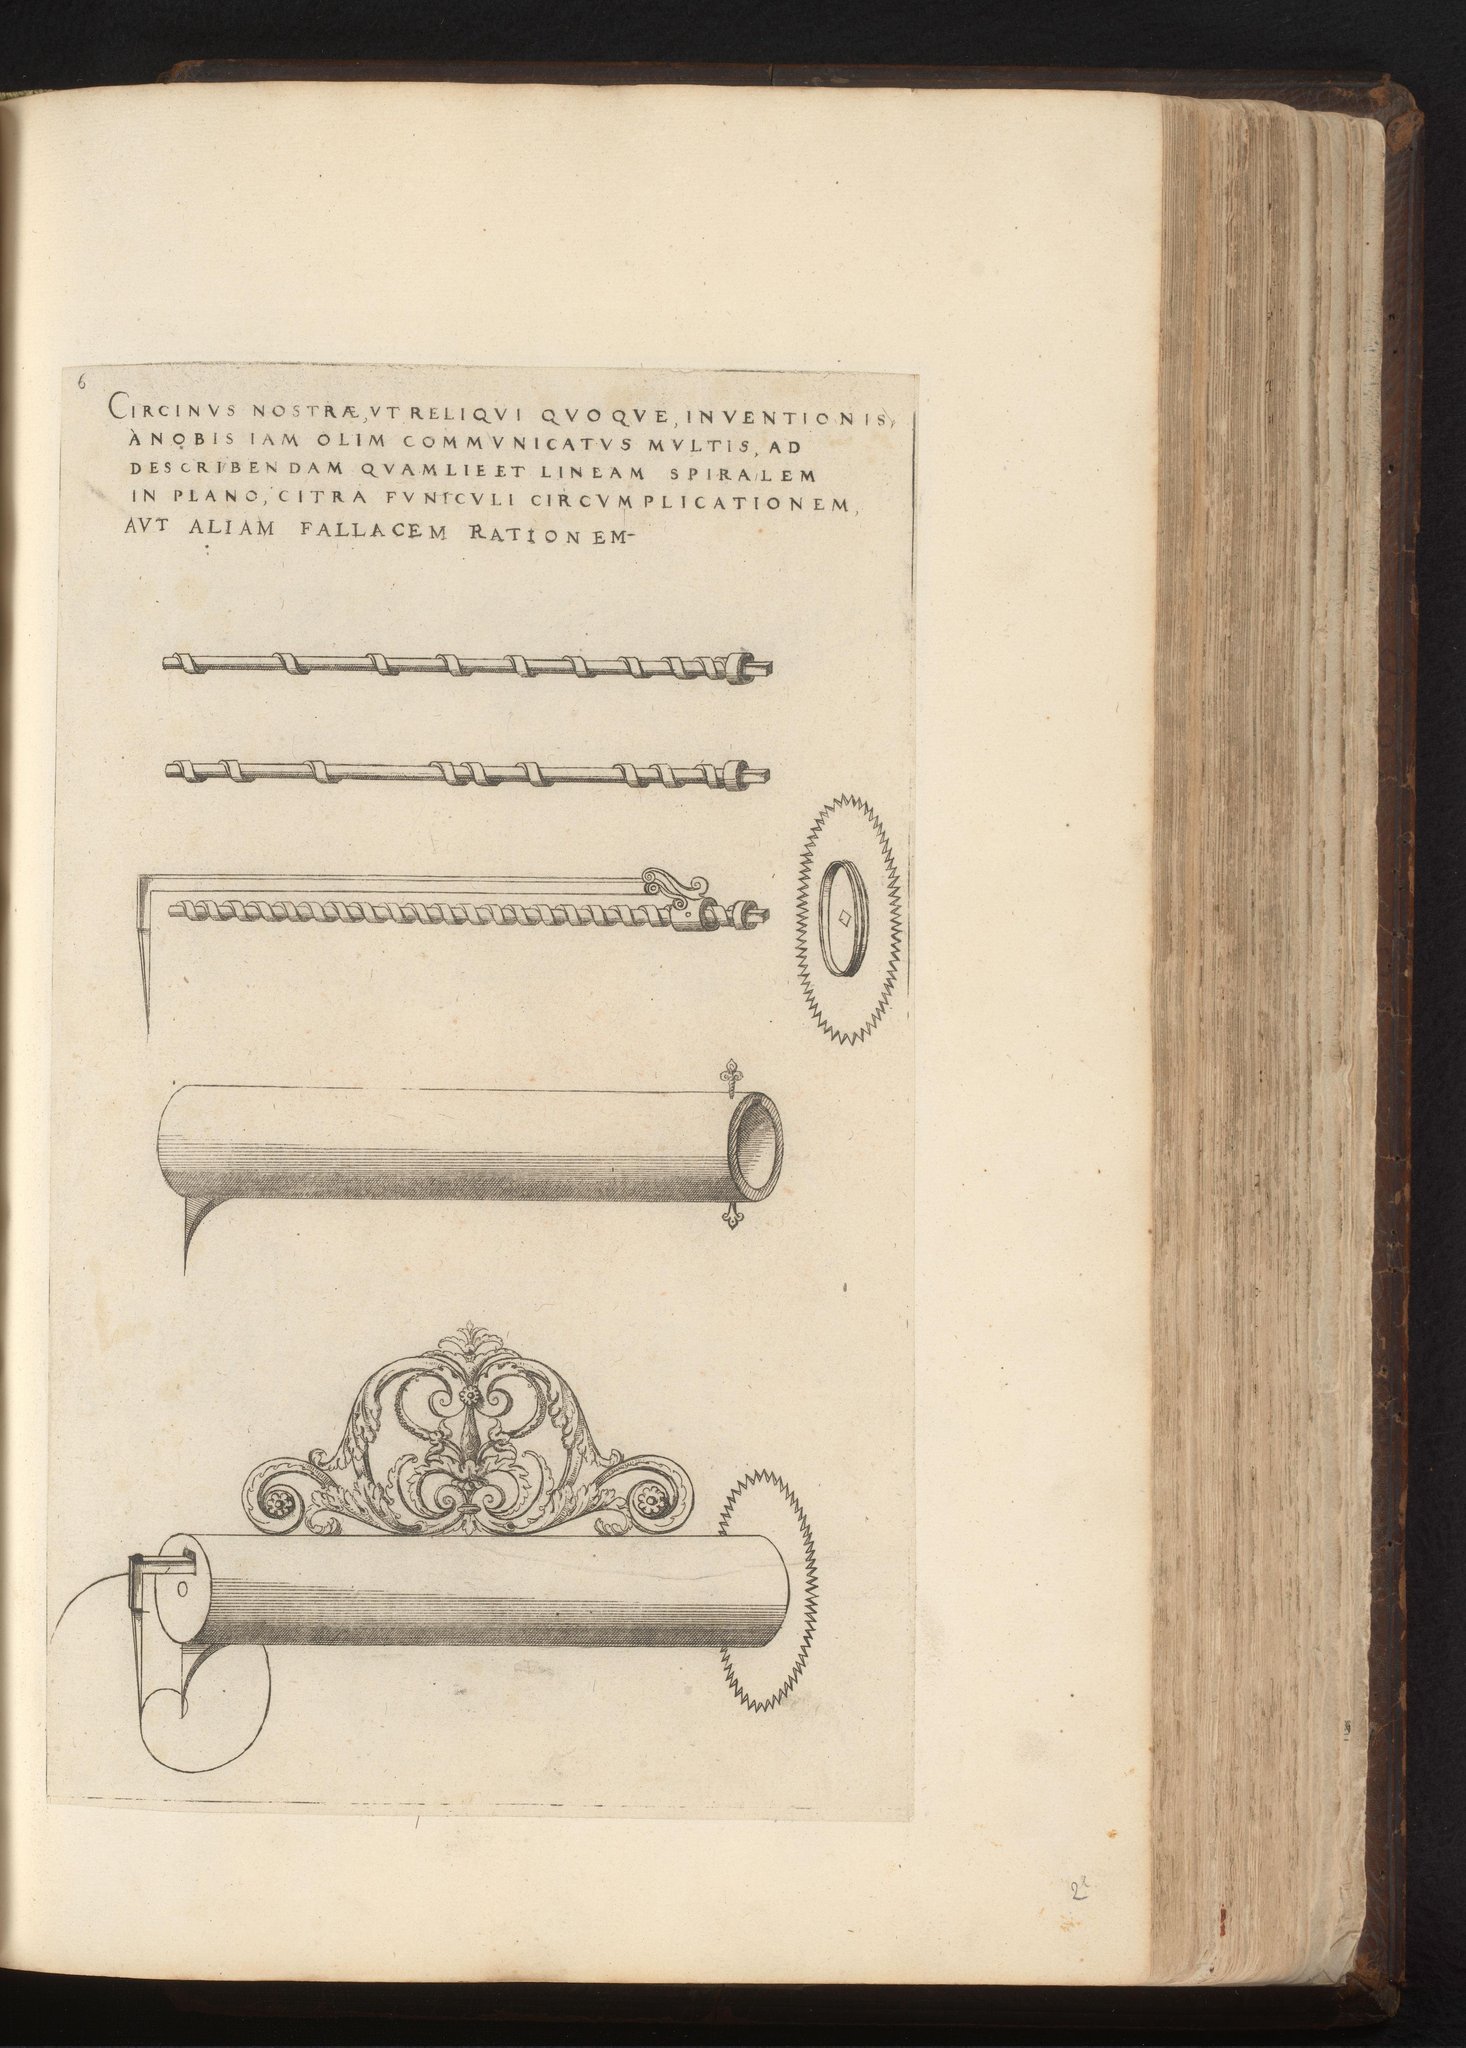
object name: print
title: Passer om spiralen mee te tekenen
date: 1579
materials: paper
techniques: etching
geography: lyon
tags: drawing-instruments, compasses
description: Prent uit: Besson, Jacques. Theatre des instrumens mathematiques & mechaniques. Lyon: Barthelemy Vincent, 1579. Prent voor het eerst verschenen in de eerste editie van ca. 1569.